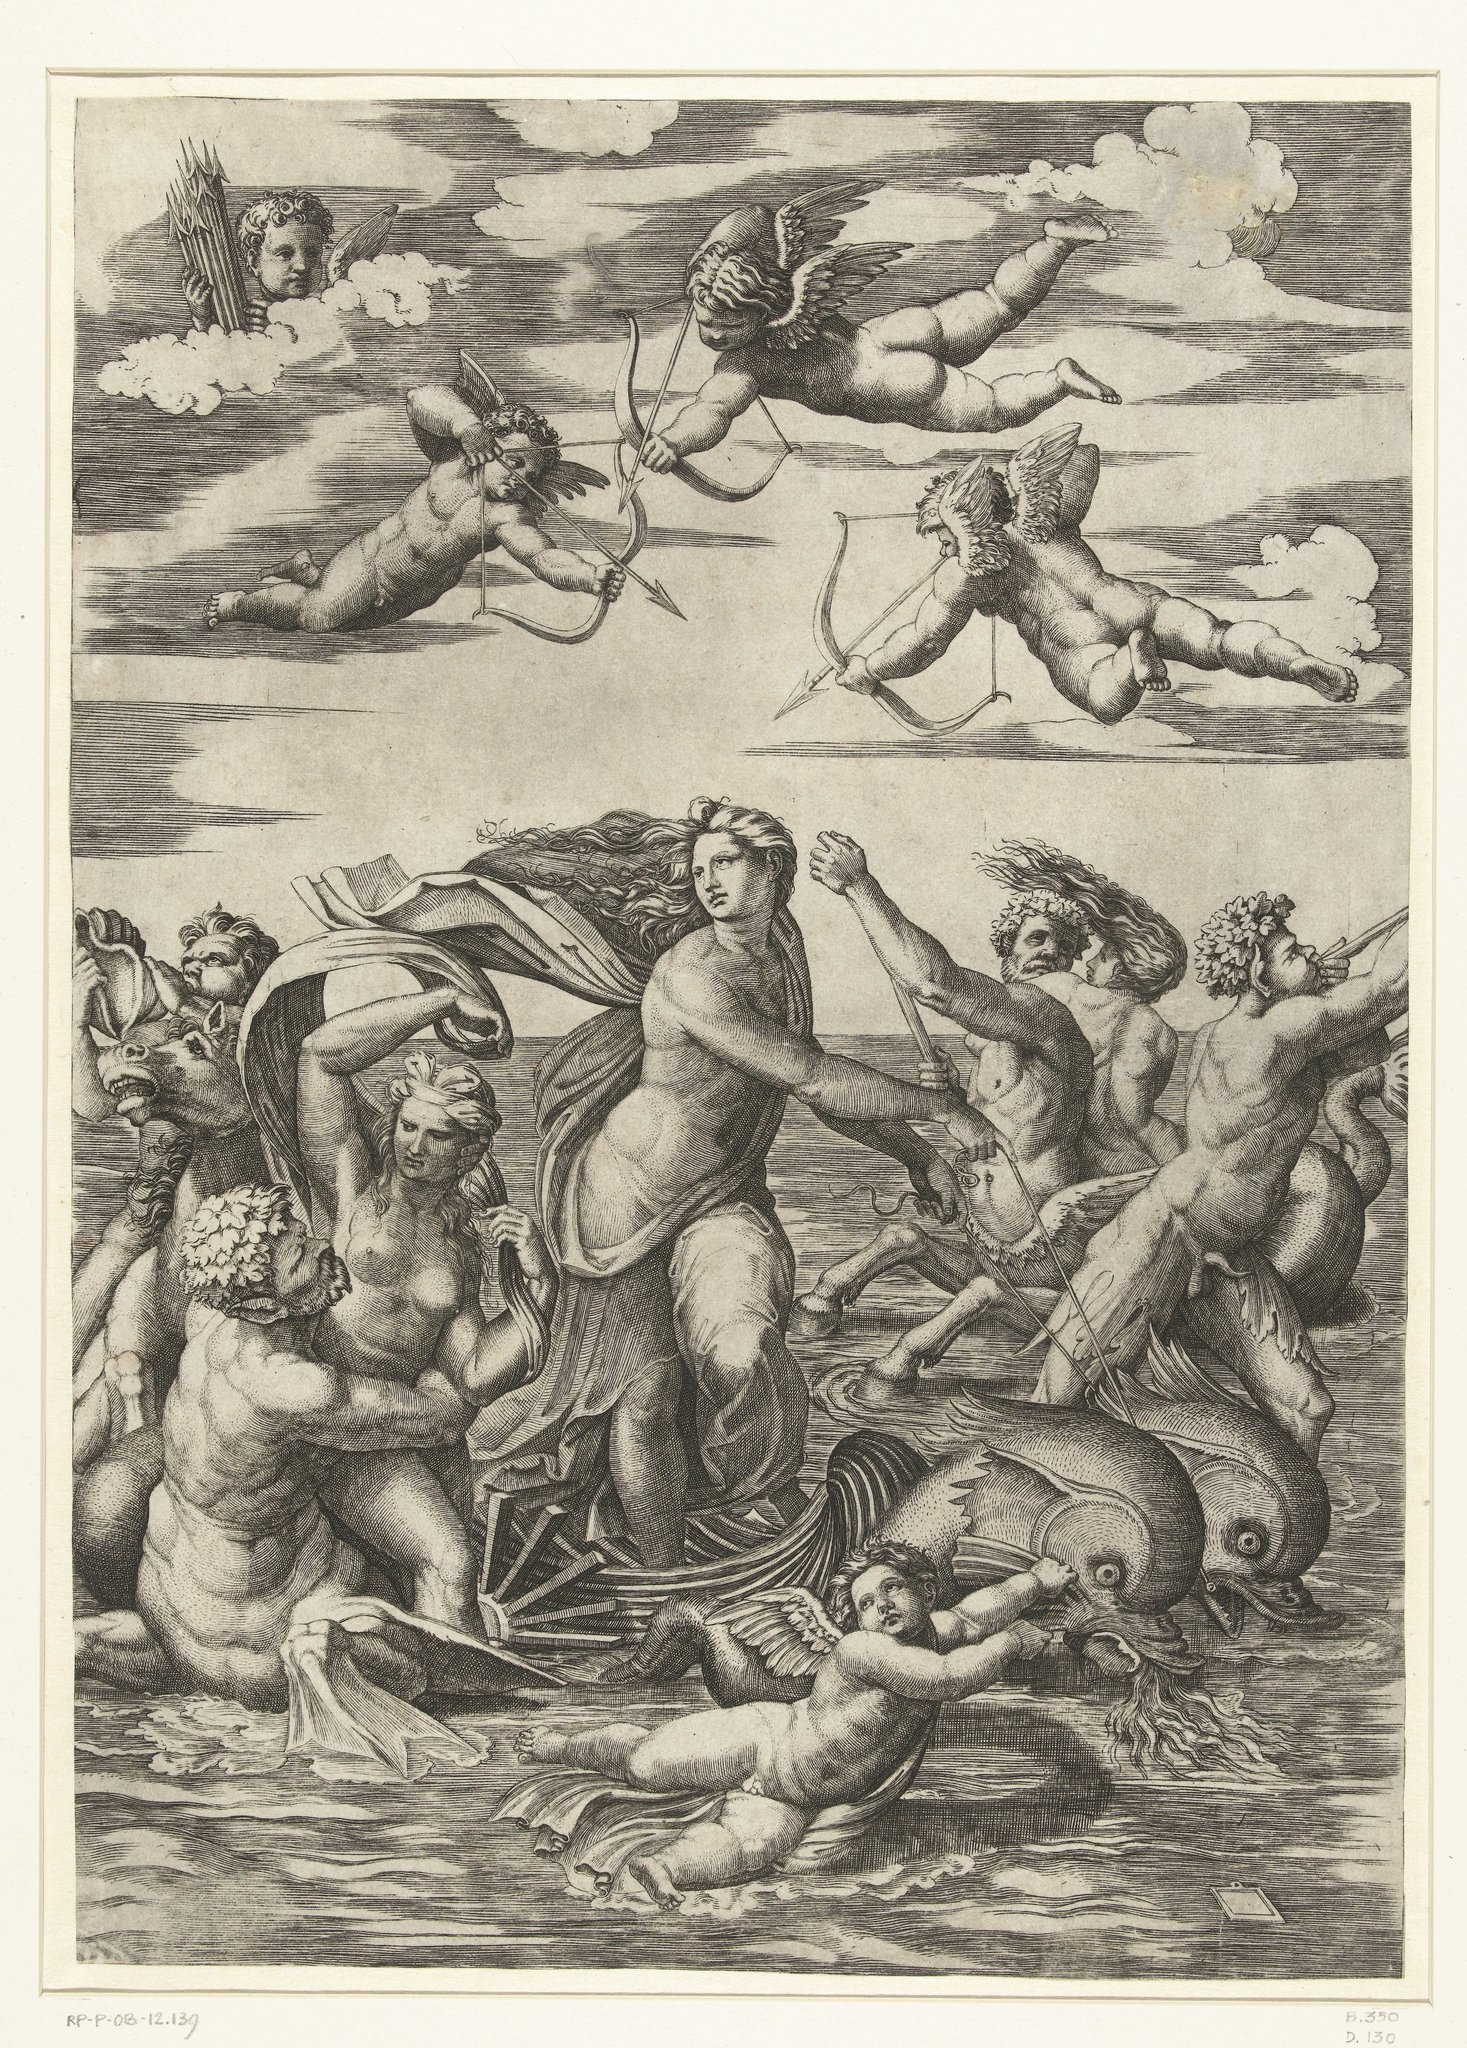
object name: print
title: Triomf van Galatea met tritons en nereïden en putti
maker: marcantonio raimondi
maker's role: print maker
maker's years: 1470-1534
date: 1515-1516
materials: paper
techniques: engraving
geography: italy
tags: triumph of galatea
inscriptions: collector's mark: Lugt 240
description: Galatea staat op een schelp en wordt voortgetrokken door dolfijnen. Zij wordt omringd door tritons en nereïden. Drie putti richten hun pijlen op Galatea.